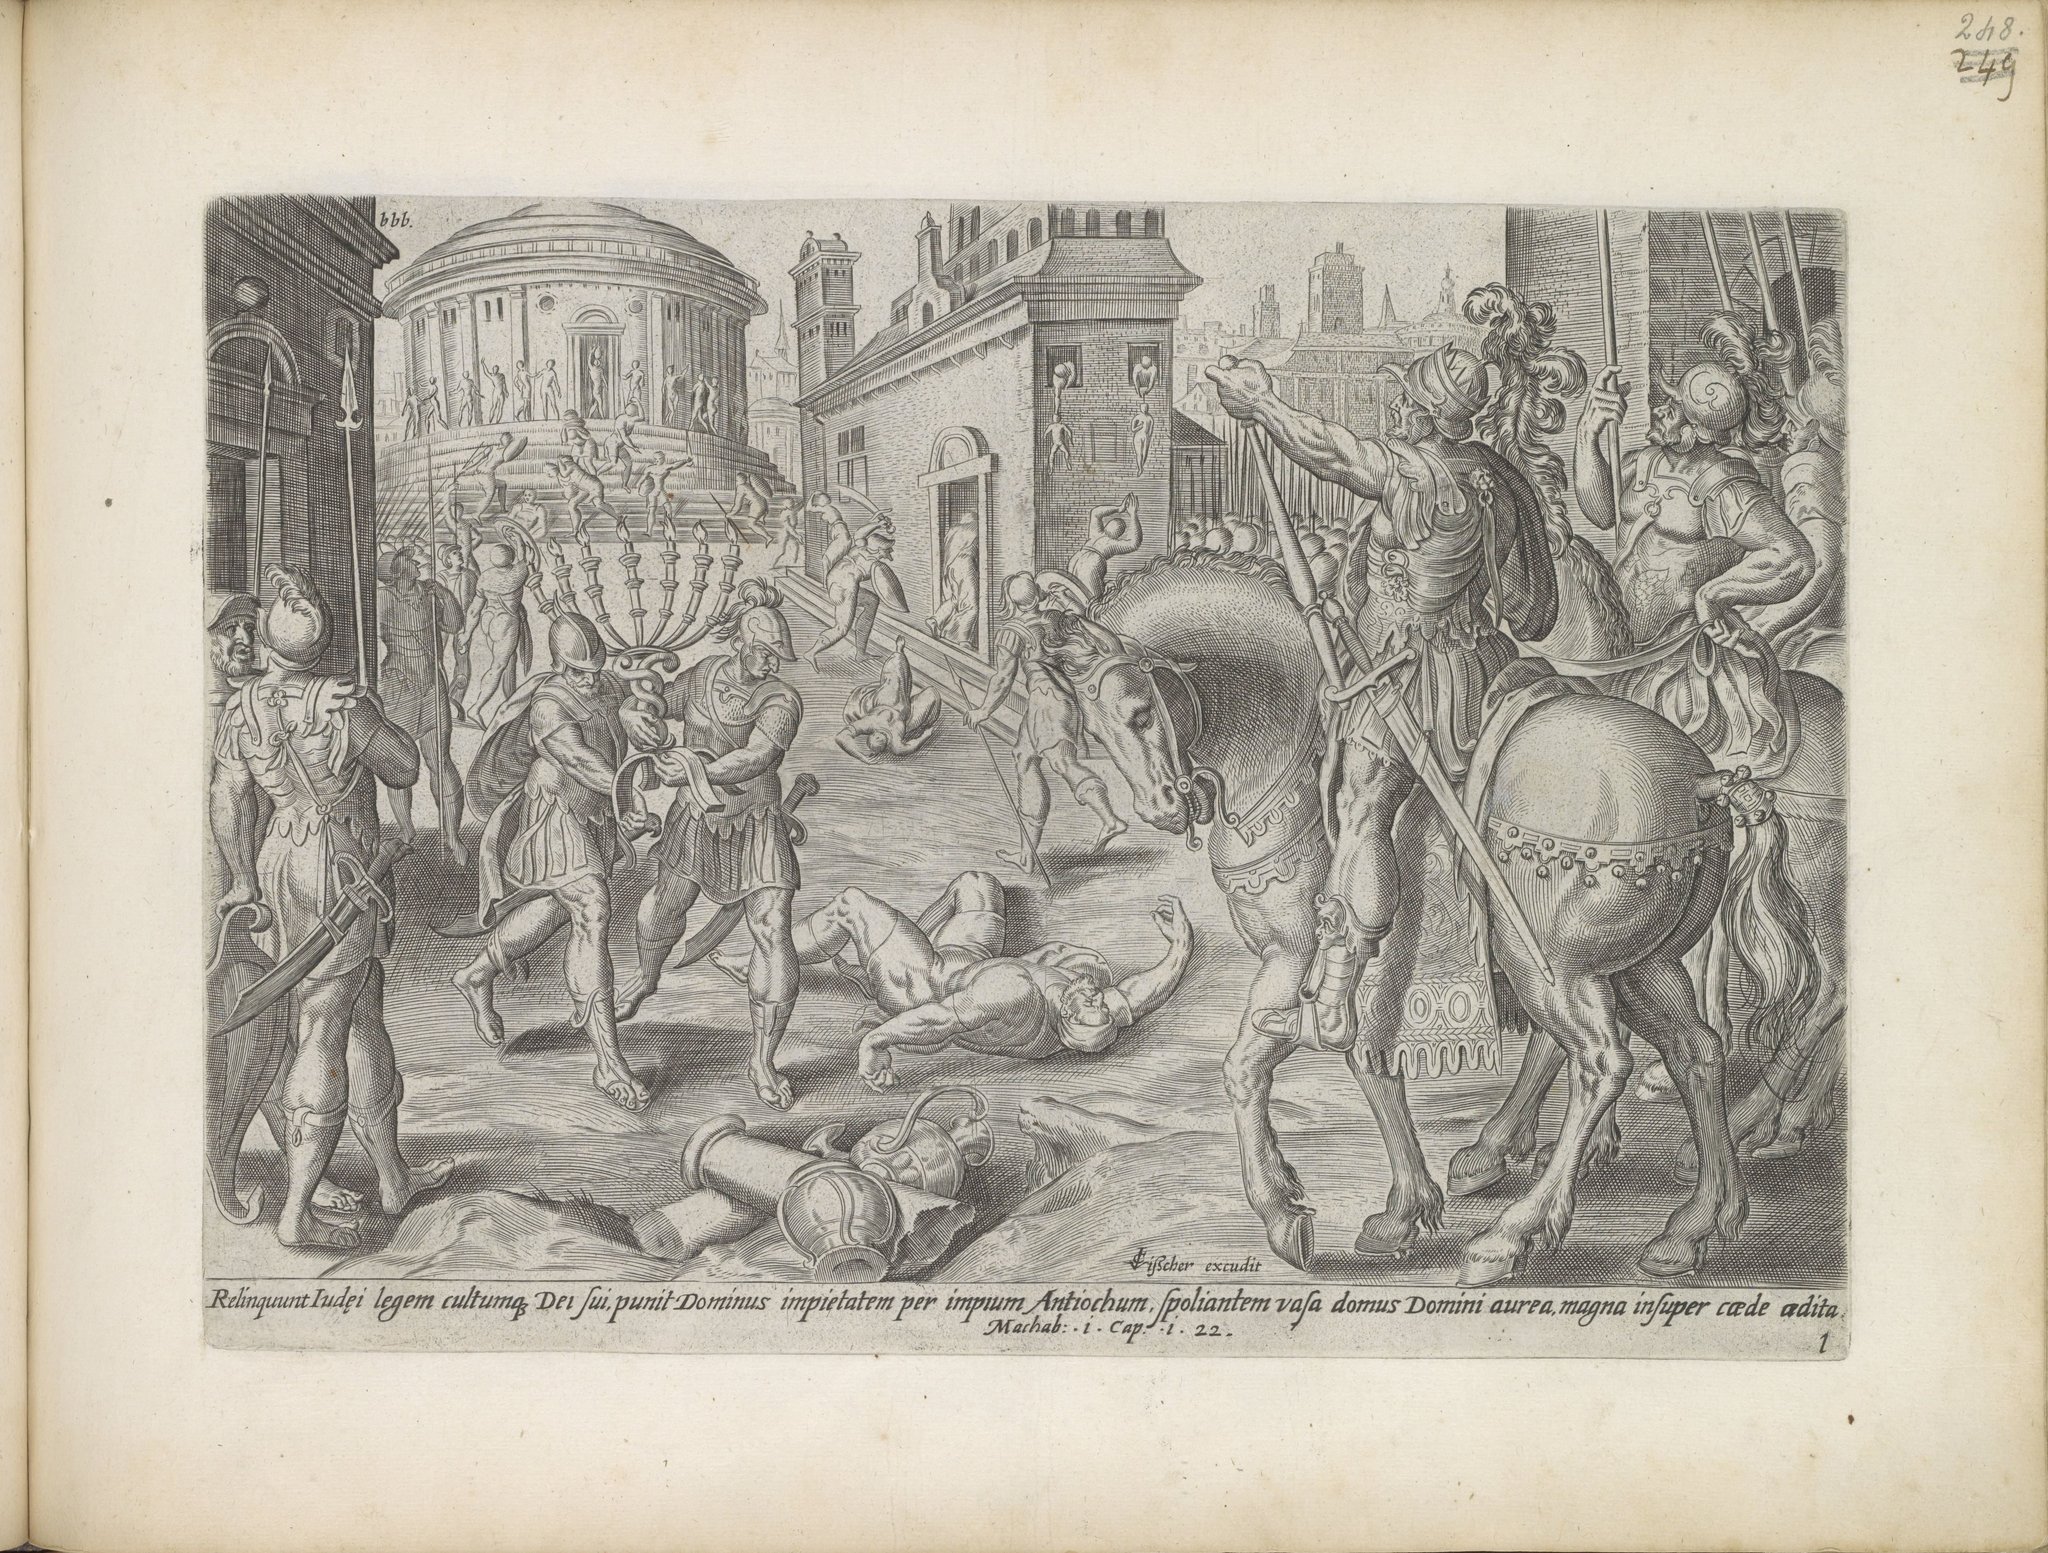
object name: album leaf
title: Geschiedenis van de Makkabeeën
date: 1643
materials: paper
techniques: engraving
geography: amsterdam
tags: antiochus iv epiphanes robbing the temple of its treasures (1 maccabees 1:21-23)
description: Na zijn overwinning op Egypte trekt Antiochus met een groot leger naar Jeruzalem. Daar rooft hij de tempel leeg en richt hij een bloedbad aan onder de inwoners. Onder de voorstelling een verwijzing in het Latijn naar de Bijbeltekst in 1 Makk. 1:22. Deze prent maakt deel uit van een album.